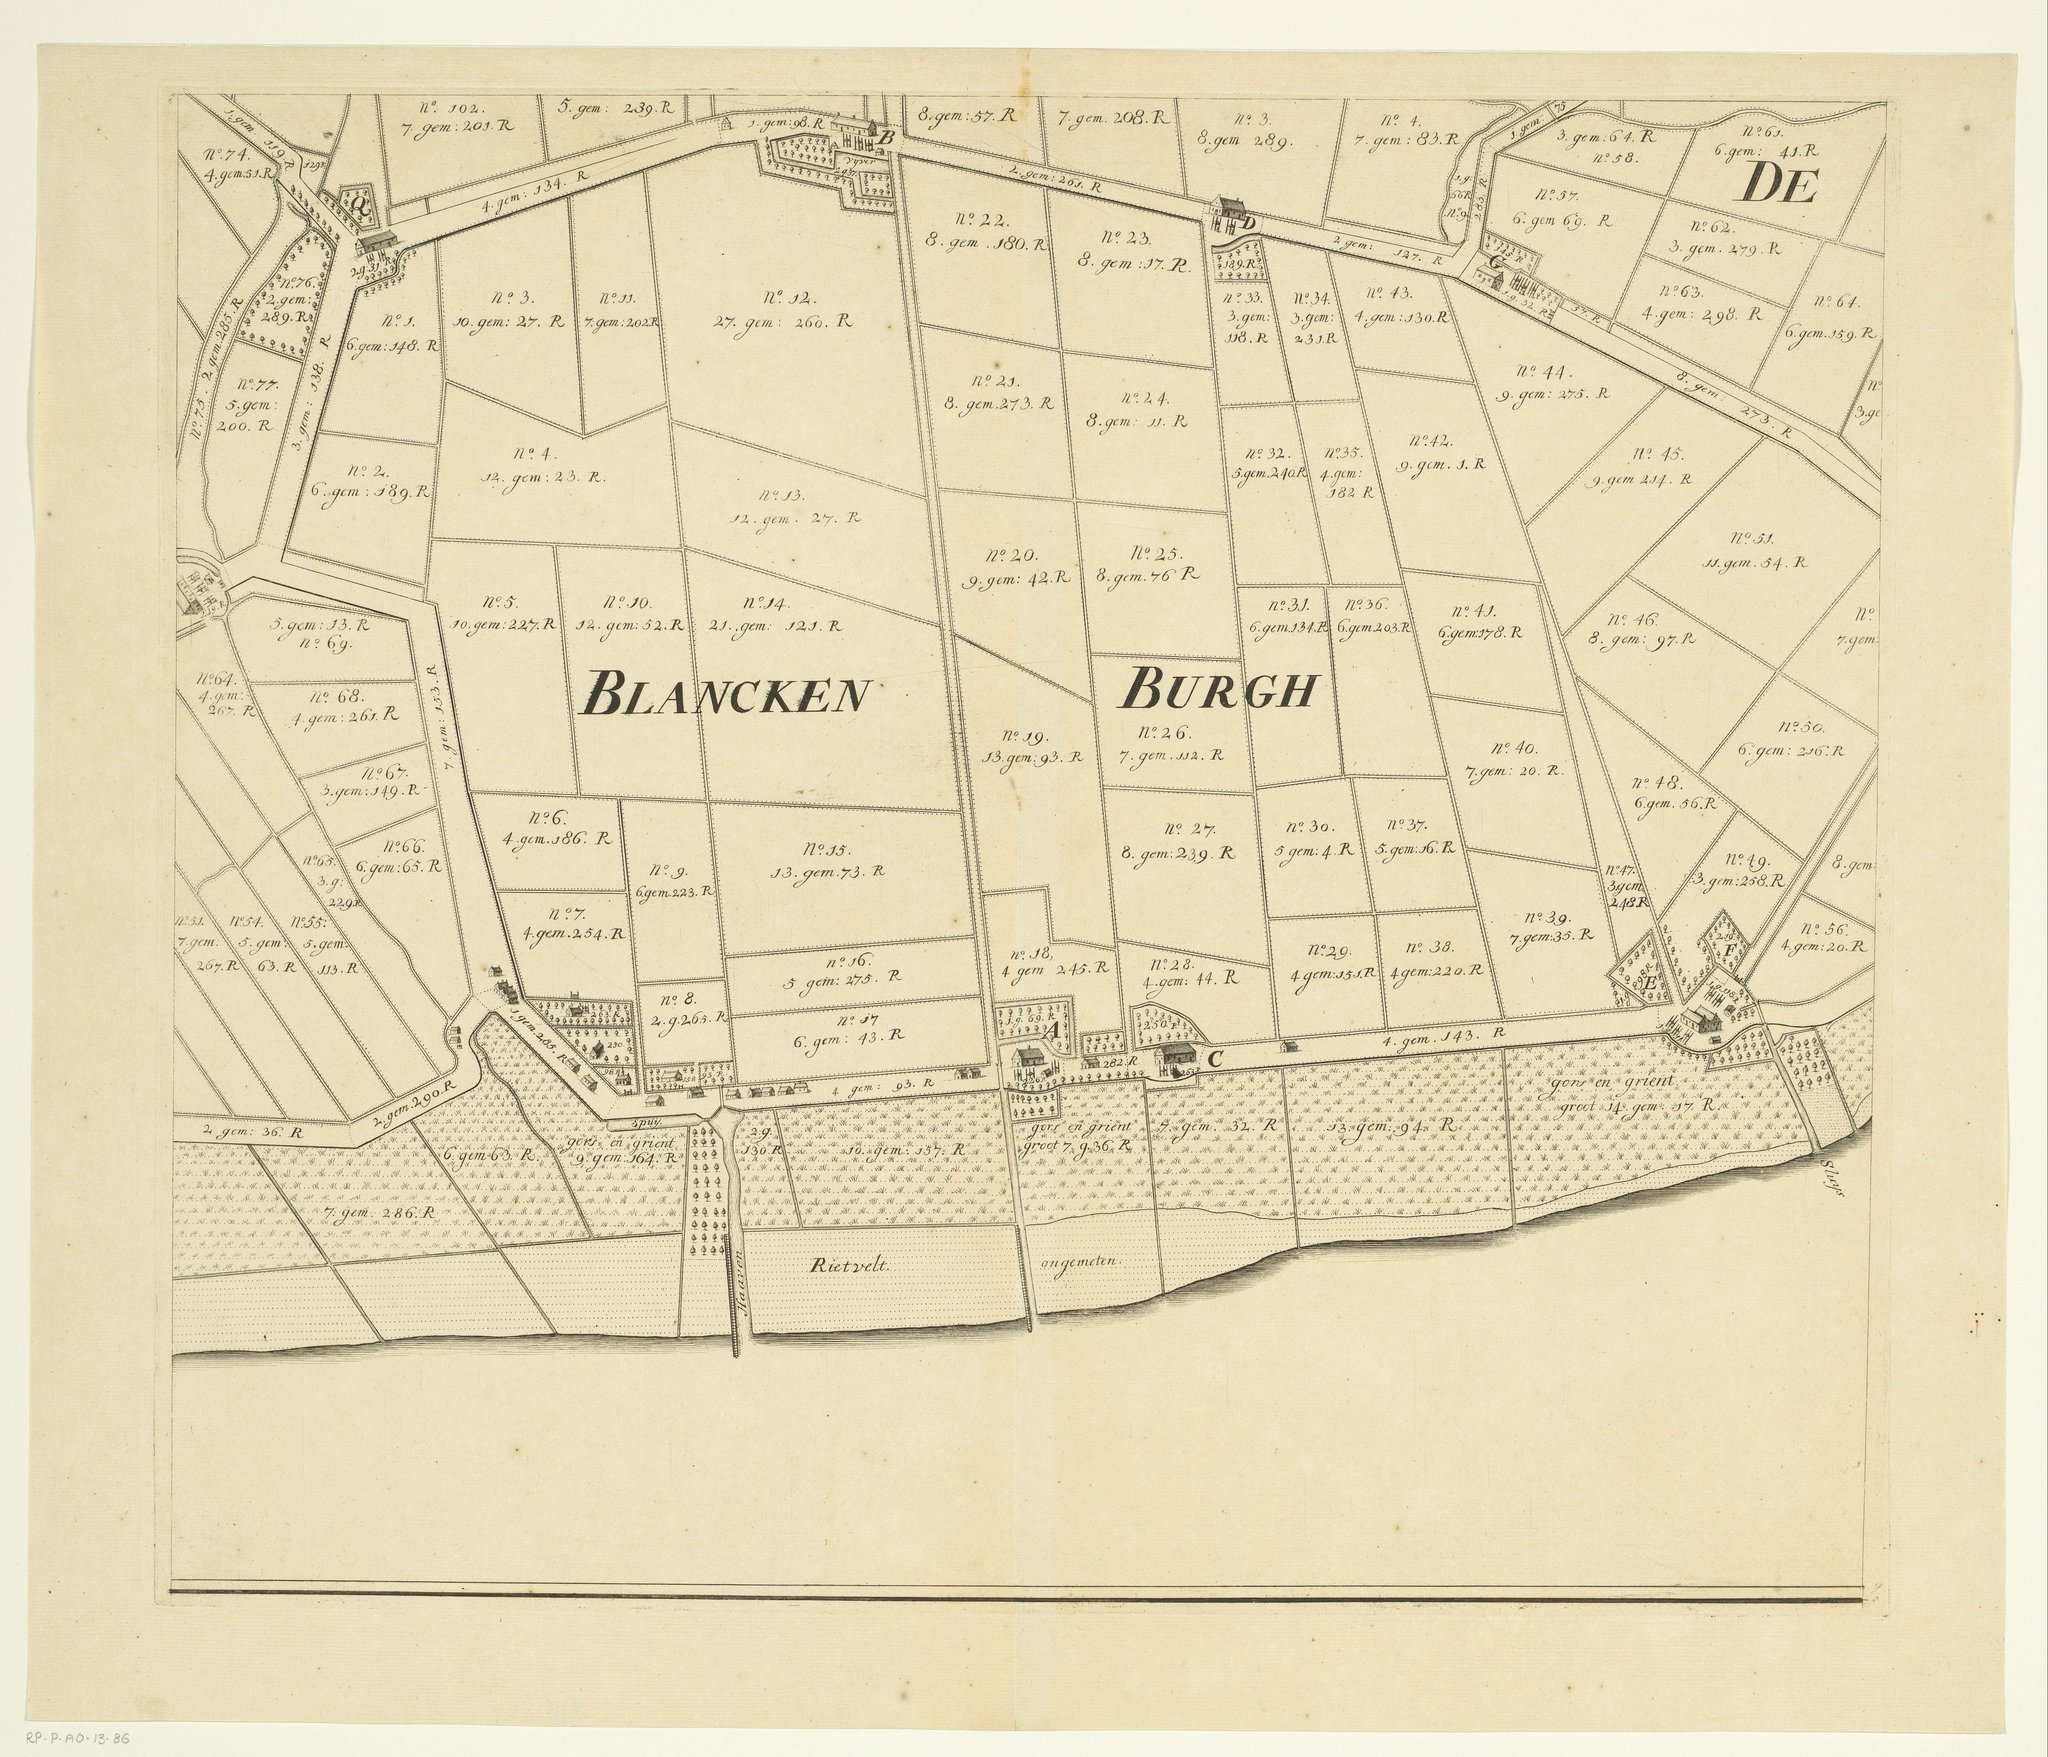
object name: map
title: Kaarte ende meetinge … van den eijlande Oudt en Nieuw Roosenburg, Blankenburg, Ruijge, en Lange Plaat, gelegen in de reviere de Maase, tusschen het landt van Holland, en de lande van Voorne en Putten …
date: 1727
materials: paper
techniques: engraving, etching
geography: the hague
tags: maps of separate countries or regions, polder, reclaimed land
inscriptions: collector's mark: Lugt 2228, collector's mark: Lugt 195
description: Deel (derde van onder) van een kaart van het eiland Rozenburg, bestaande uit acht delen.